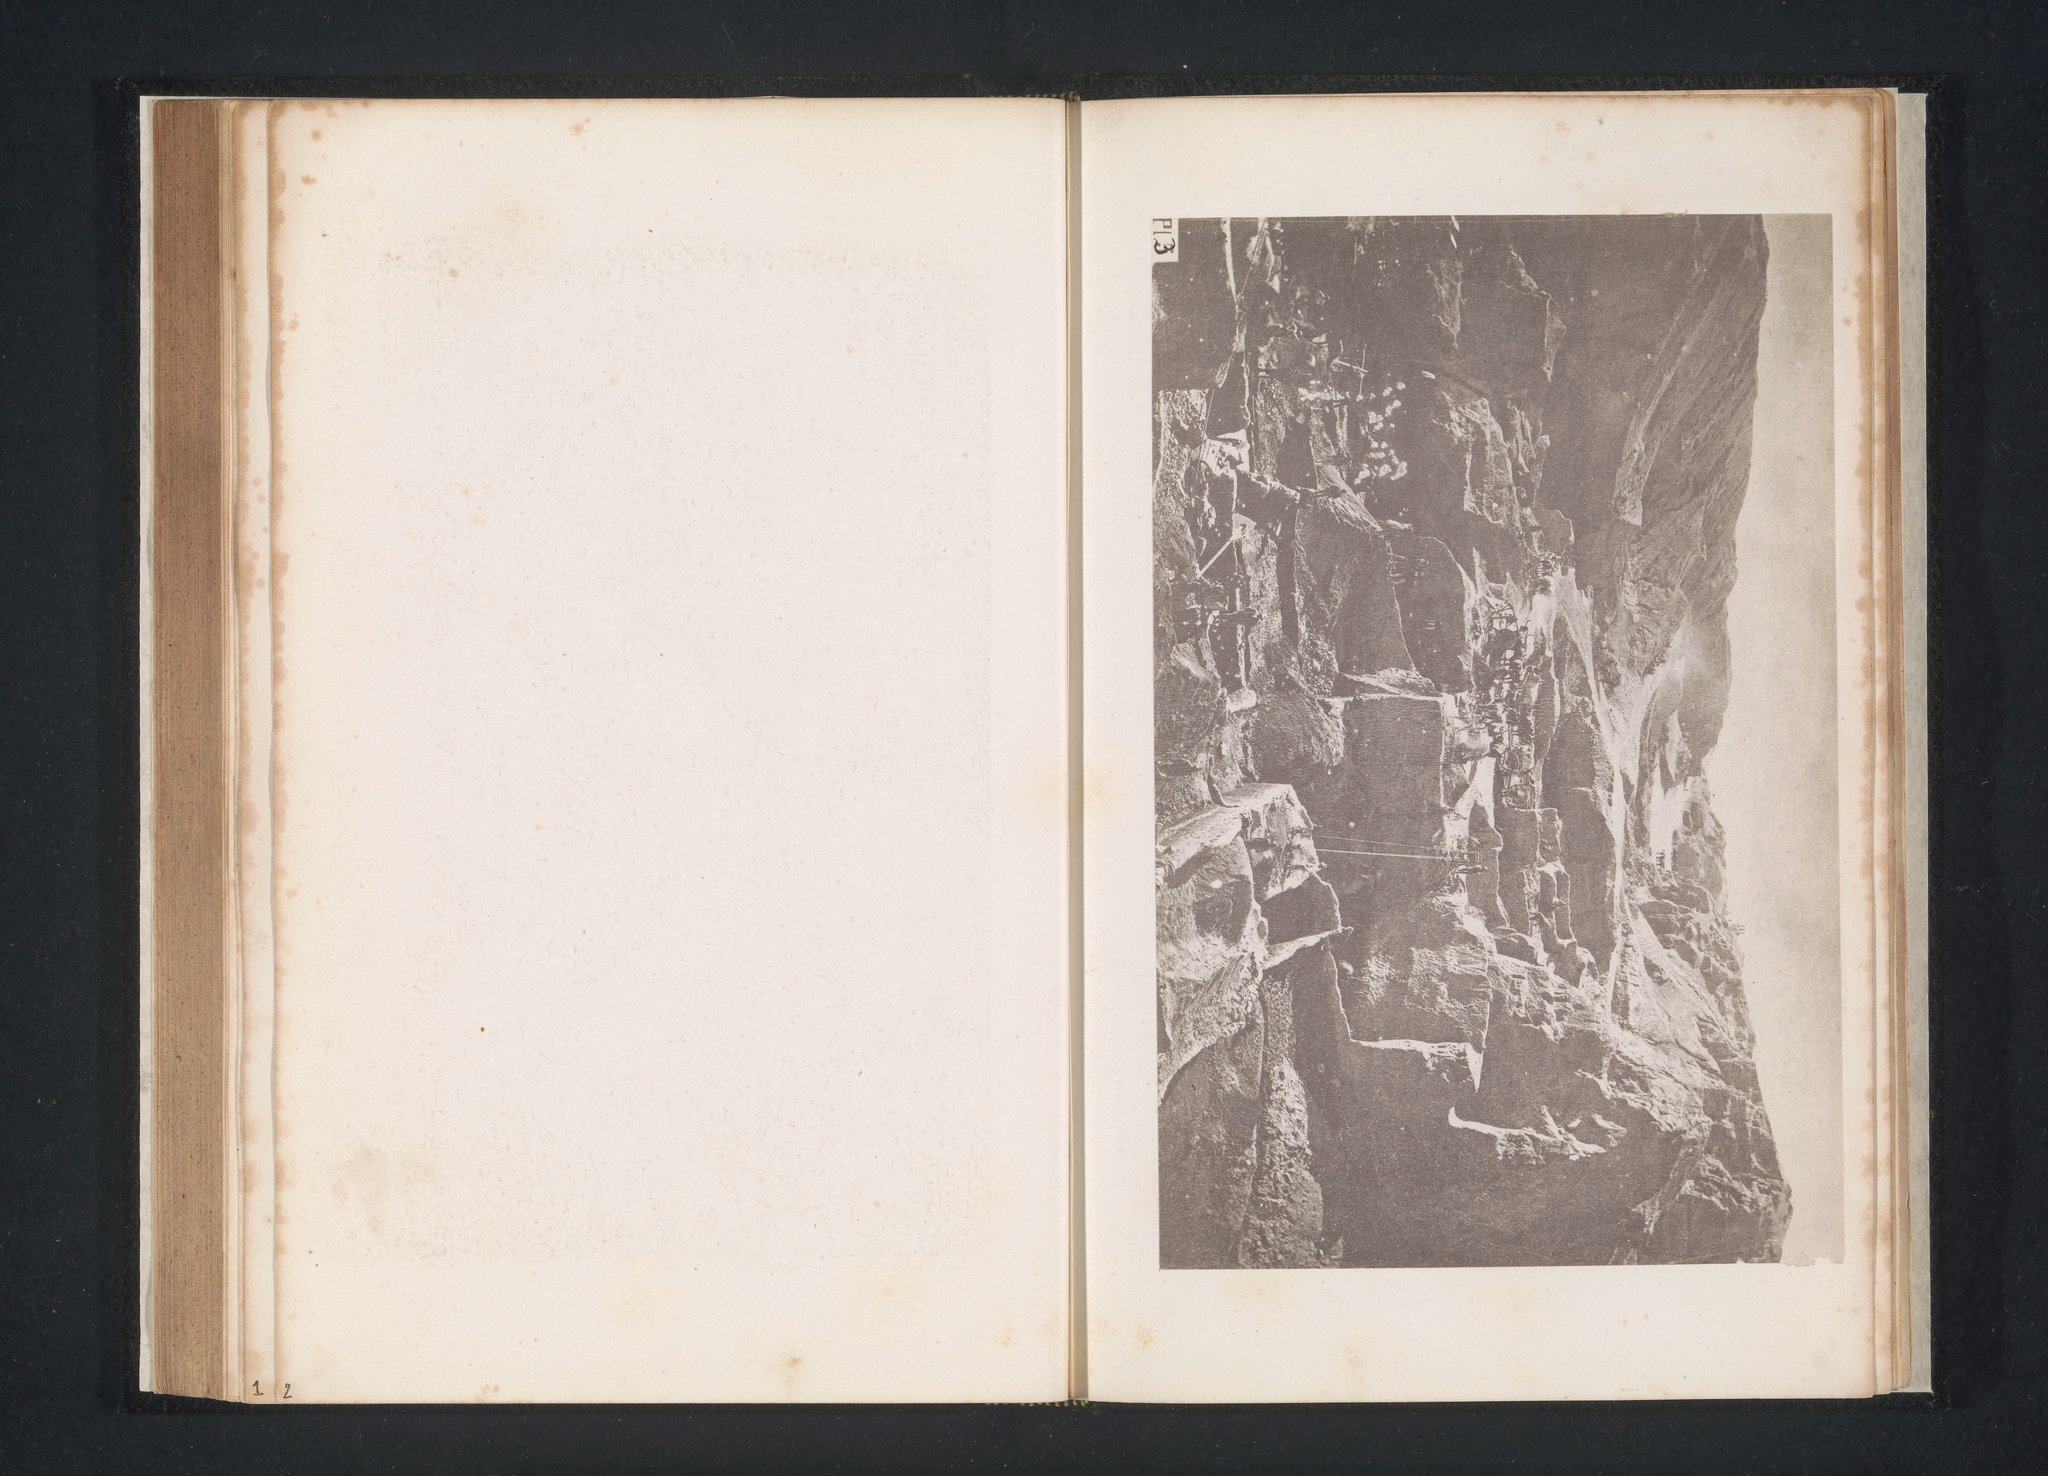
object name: page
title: Gezicht op een diamantmijn in Zuid-Afrika, vermoedelijk bij Kimberley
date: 1870-1880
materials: paper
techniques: photograph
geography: south africa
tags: mine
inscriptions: number: ‘Pl. 3’